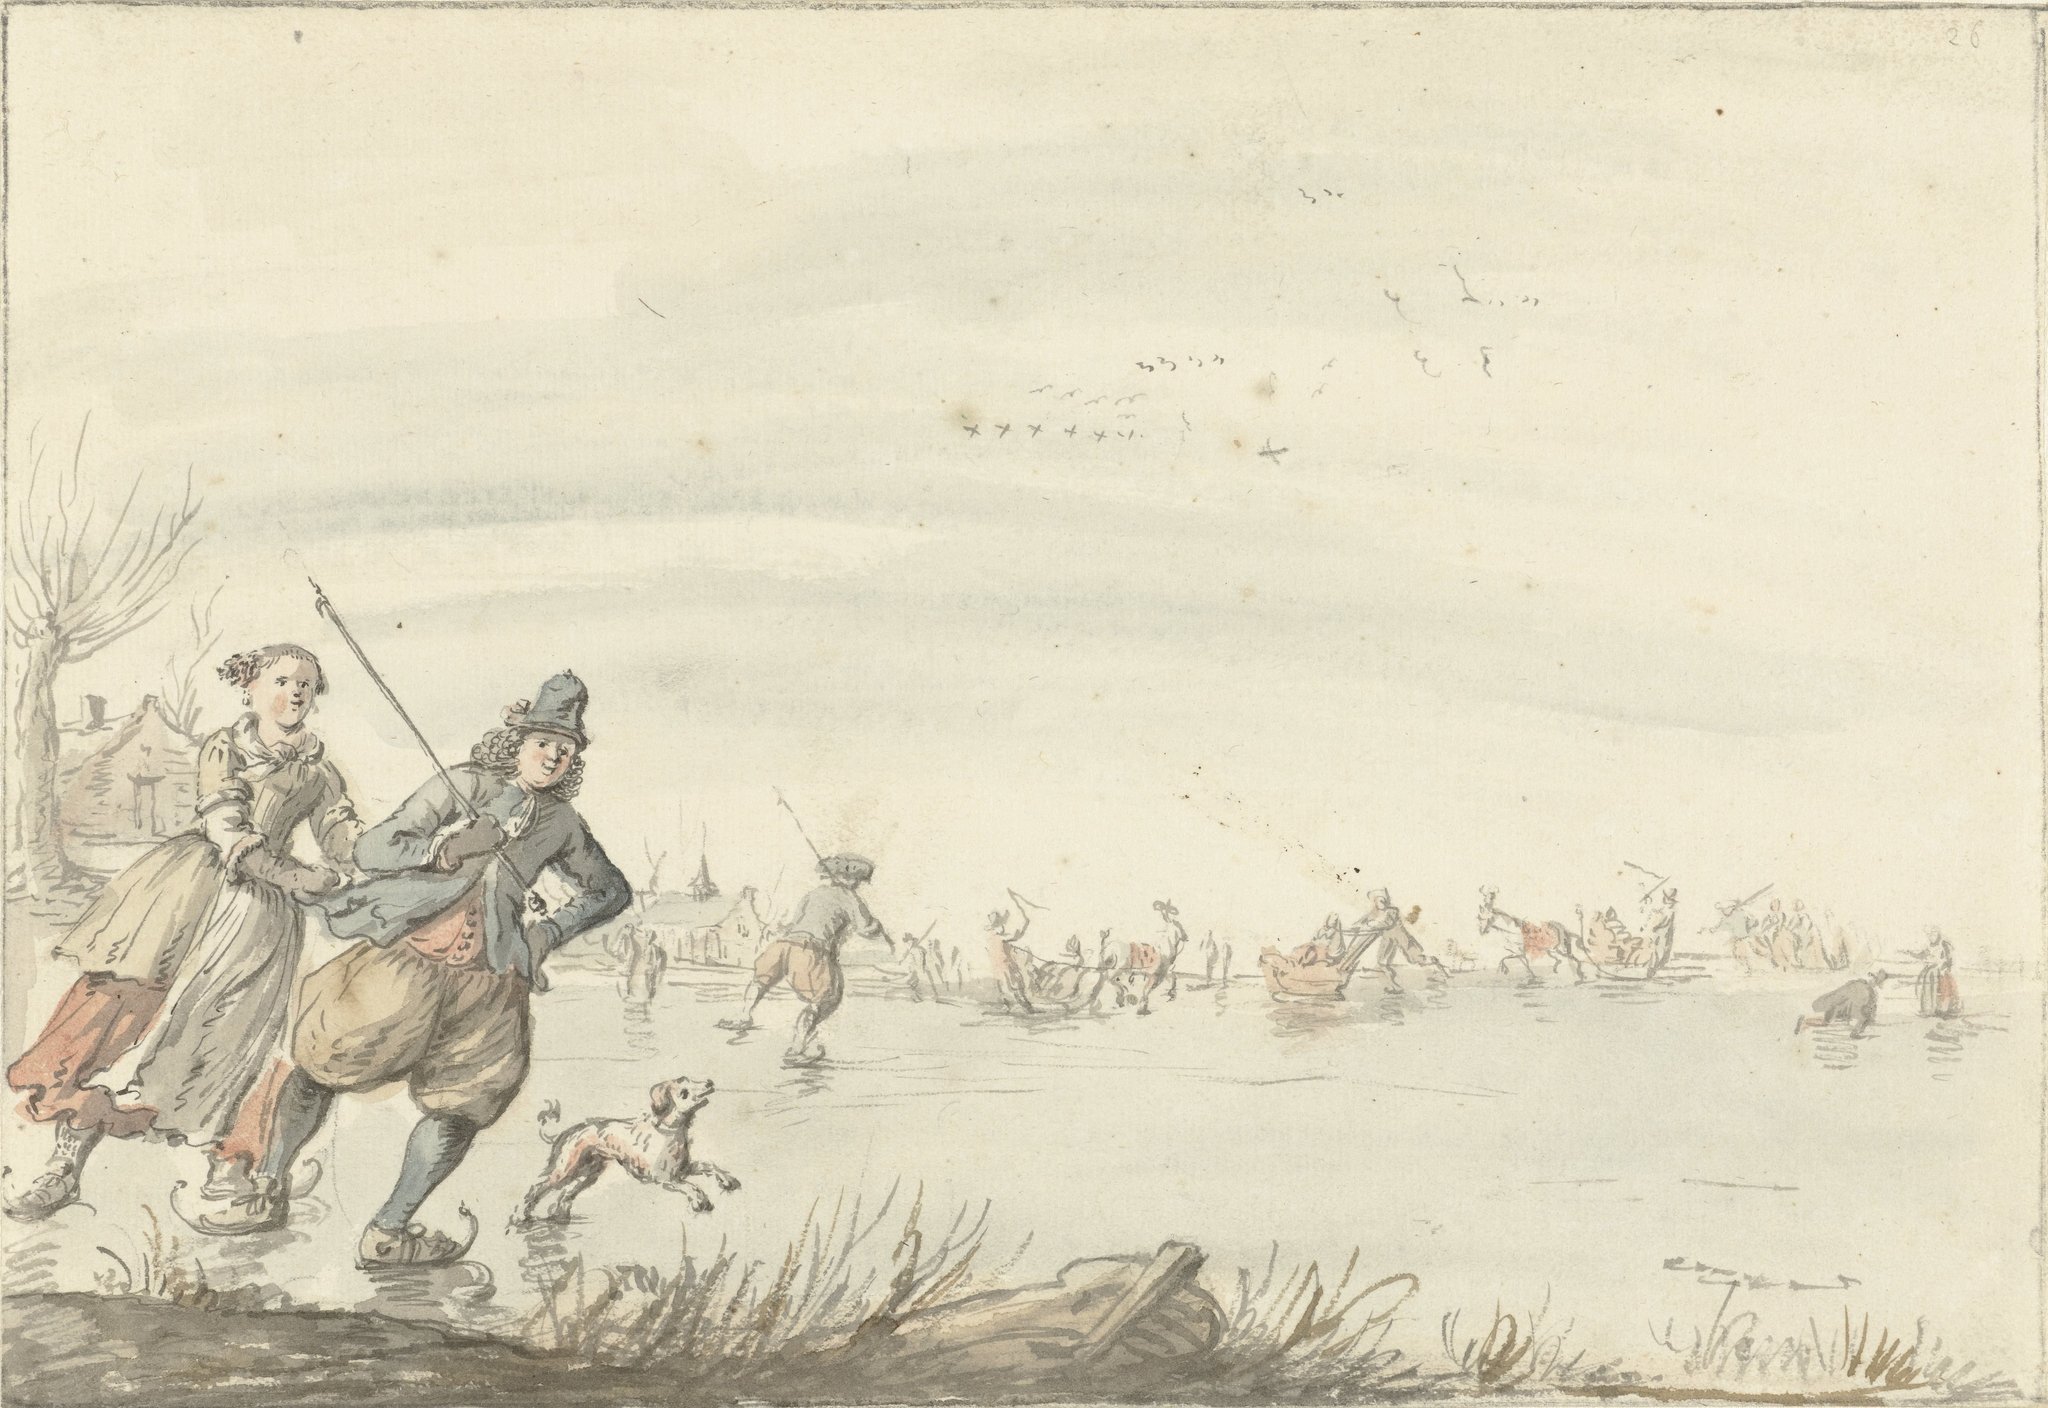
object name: drawing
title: Wintergezicht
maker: gerrit grasdorp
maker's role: draughtsman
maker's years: 1659-1716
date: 1661-1693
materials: ink, paper, watercolor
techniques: brush, pen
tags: winter sports, ice ~ freezing weather